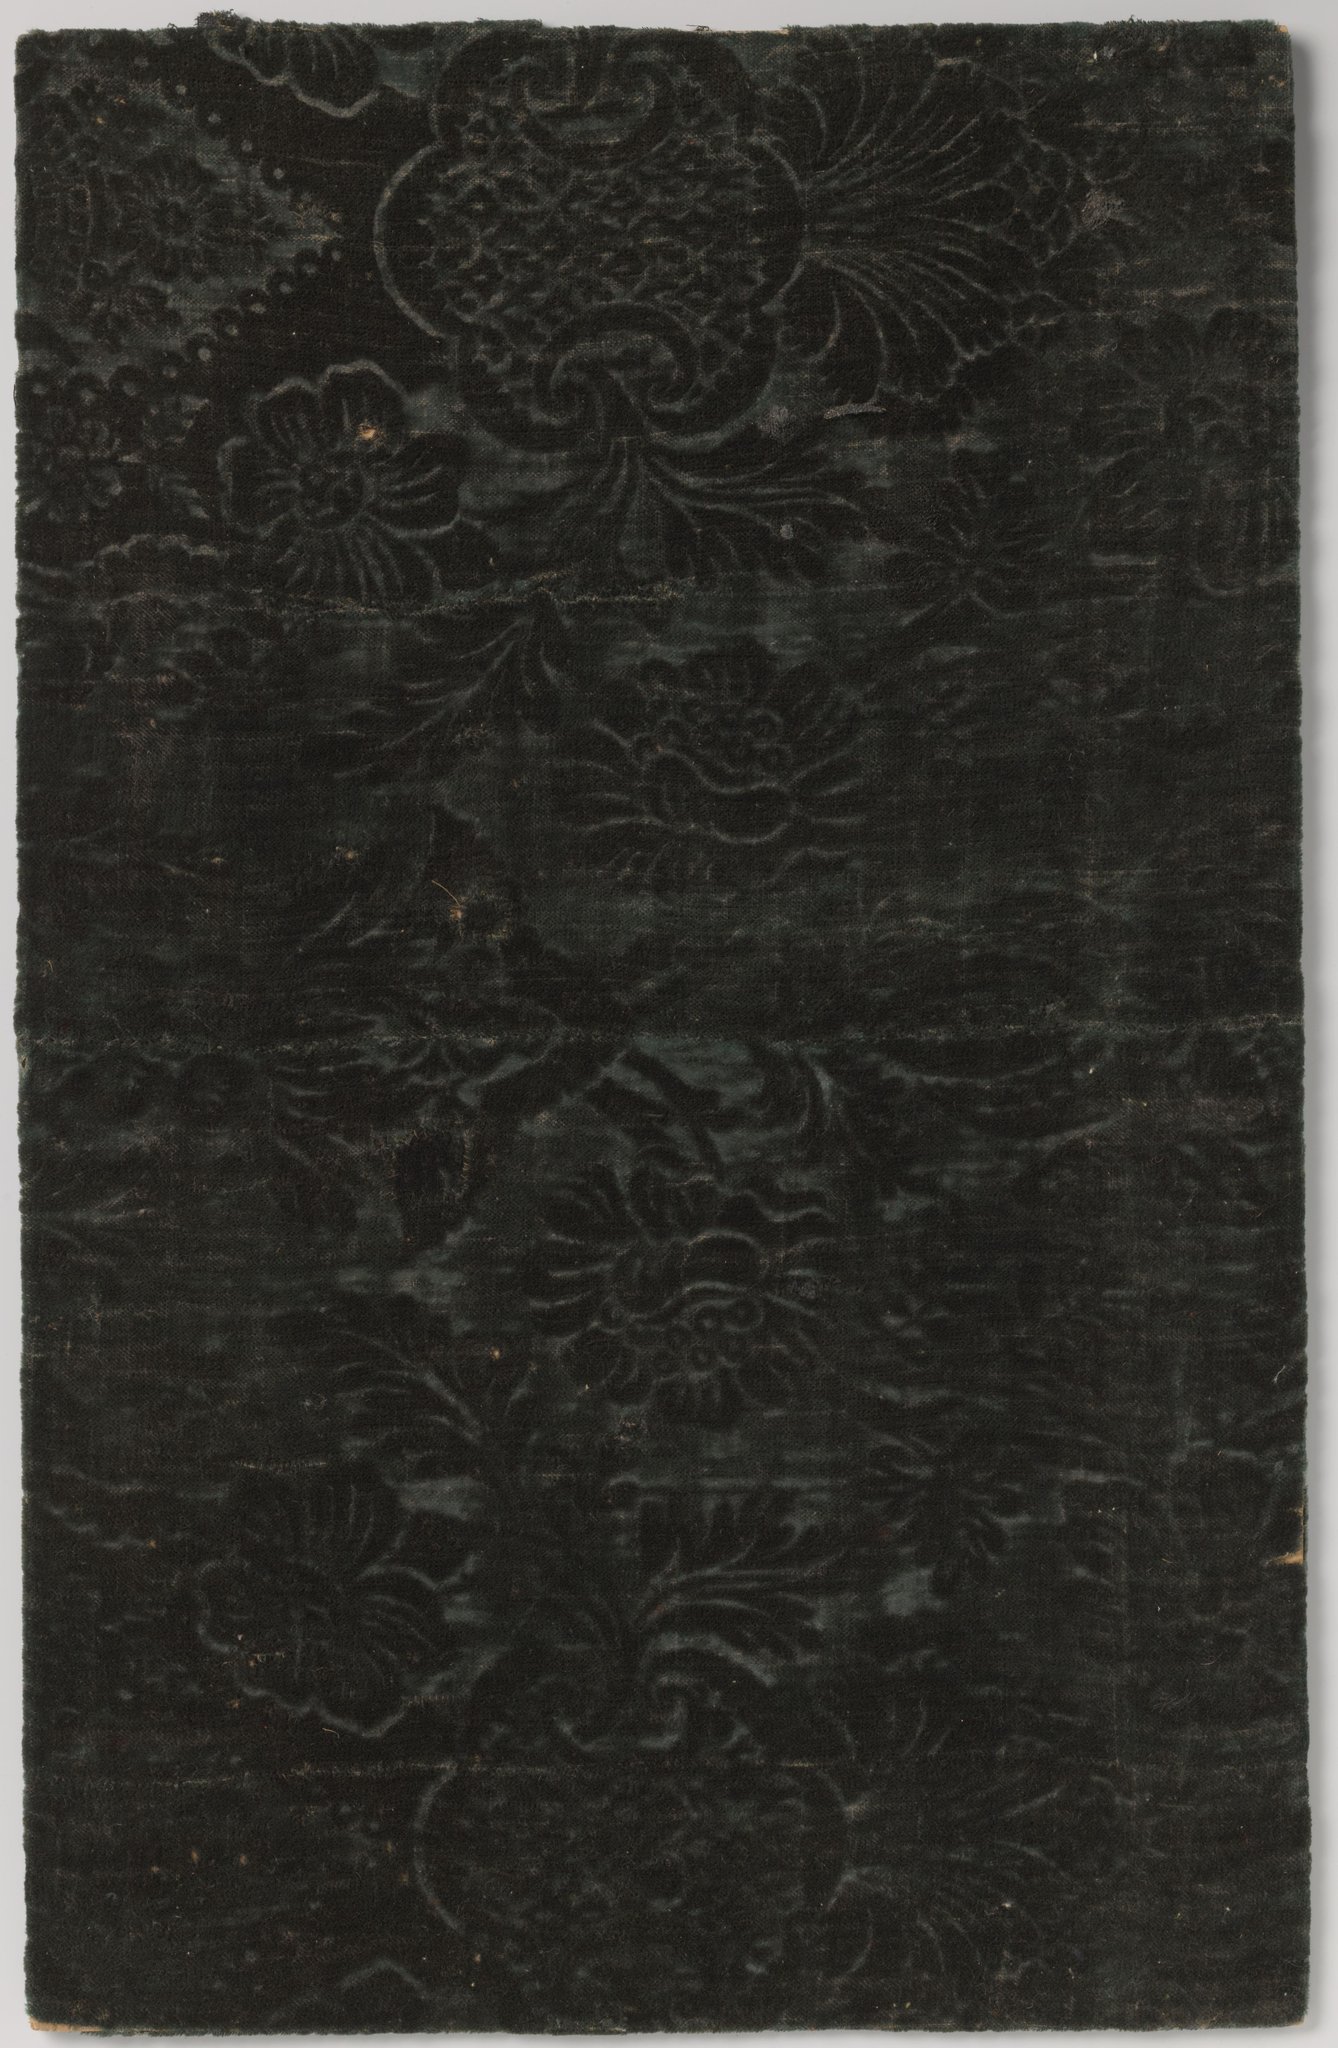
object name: bekledingsstof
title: Trijp, groen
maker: Anonymous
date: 1600-1800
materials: linen, textile, hair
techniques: pressing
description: Fragment donkergroene bespanningsstof met floraal patroon, vermoedelijk van geperst trijp. Achterzijde stevig linnen.